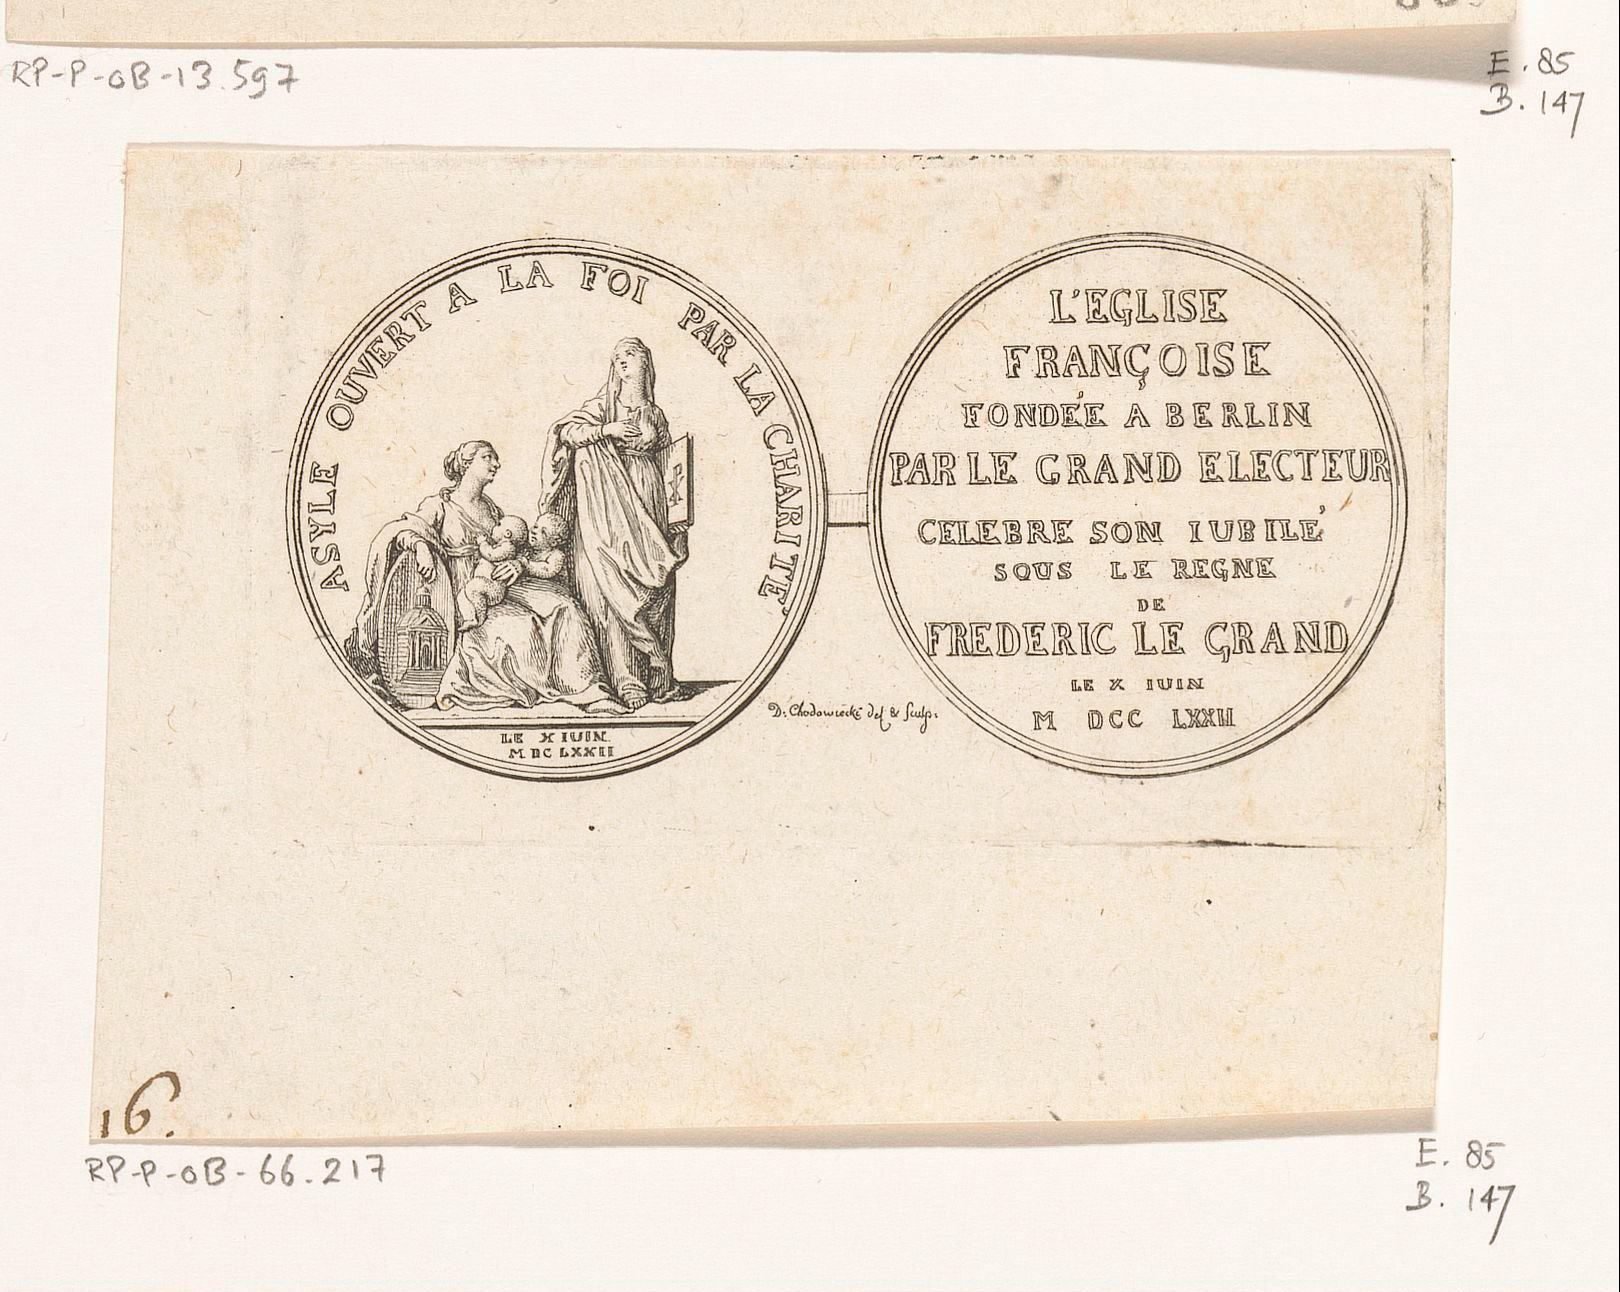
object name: print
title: Medaille voor het jubileum van de Franse kerk in Berlijn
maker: daniel nikolaus chodowiecki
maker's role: draughtsman, print maker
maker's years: 1726-1801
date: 1772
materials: paper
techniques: etching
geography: berlin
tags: charity, 'caritas'; 'carità' (ripa) ~ one of the three theological virtues, faith, 'fides'; 'fede', 'fede catholica', 'fede christiana', 'fede christiana catholica' (ripa) ~ one of the three theological virtues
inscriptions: collector's mark: Lugt 240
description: Prent van de medaille die werd geslagen ter ere van het 100 jarig jubileum van de Franse kerk te Berlijn. Na de herroeping van het Edict van Nantes in 1685 was een grote groep Franse hugenoten gevlucht naar Parijs. Op het schild is de Französischer Dom te zien, gebouwd tussen 1701 en 1705.